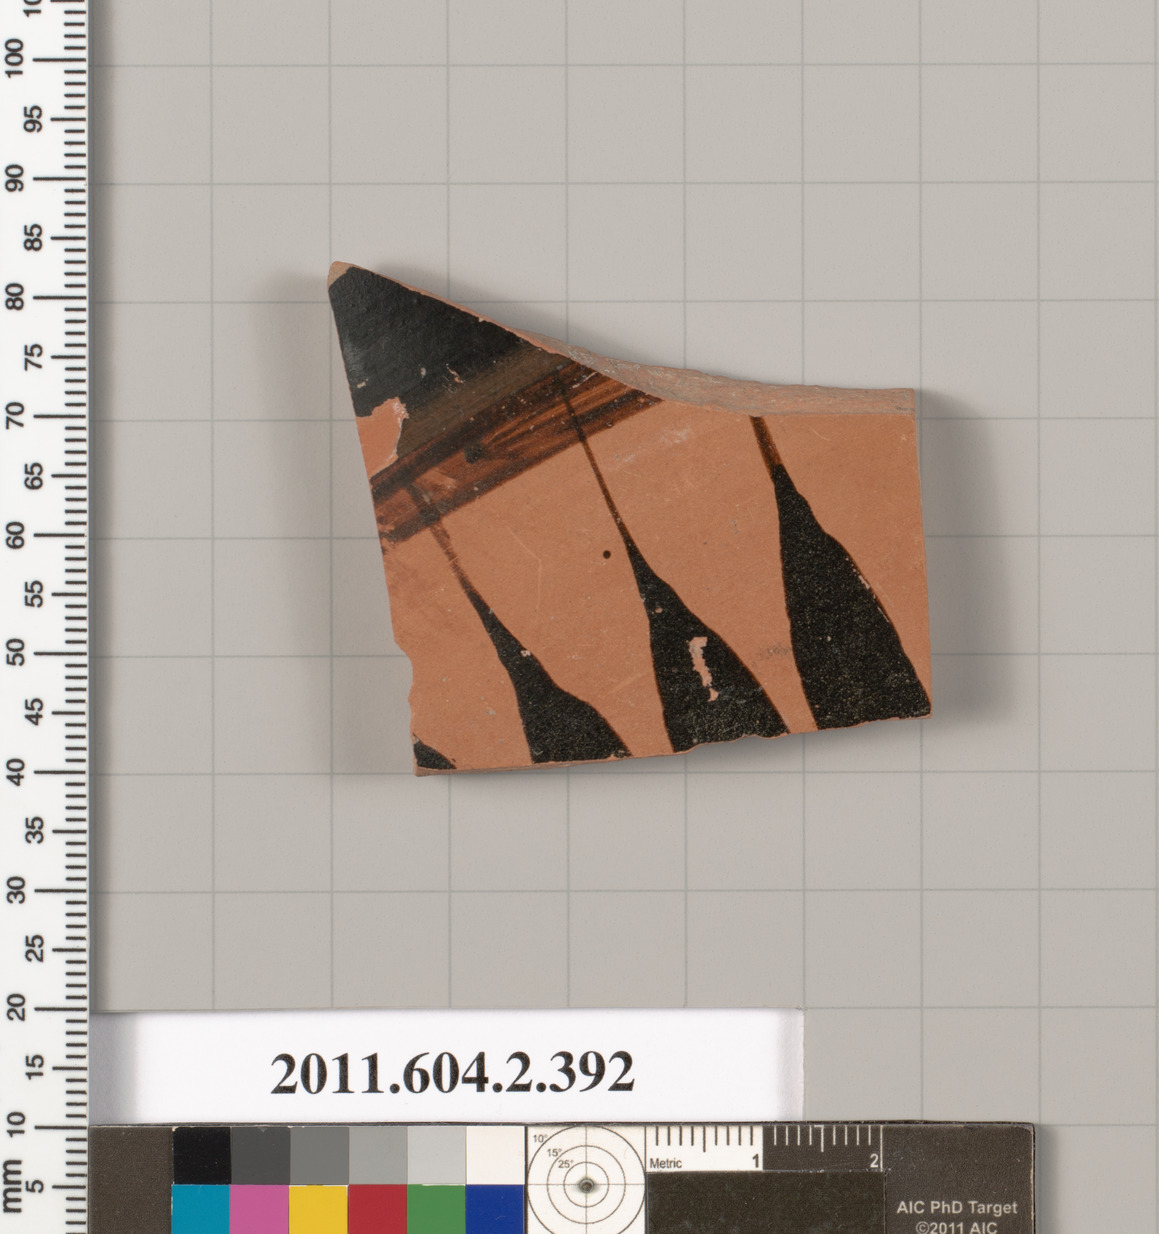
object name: column krater fragment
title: Terracotta fragment of a column-krater (bowl for mixing wine and water)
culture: greek, attic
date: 460-440 BCE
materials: terracotta